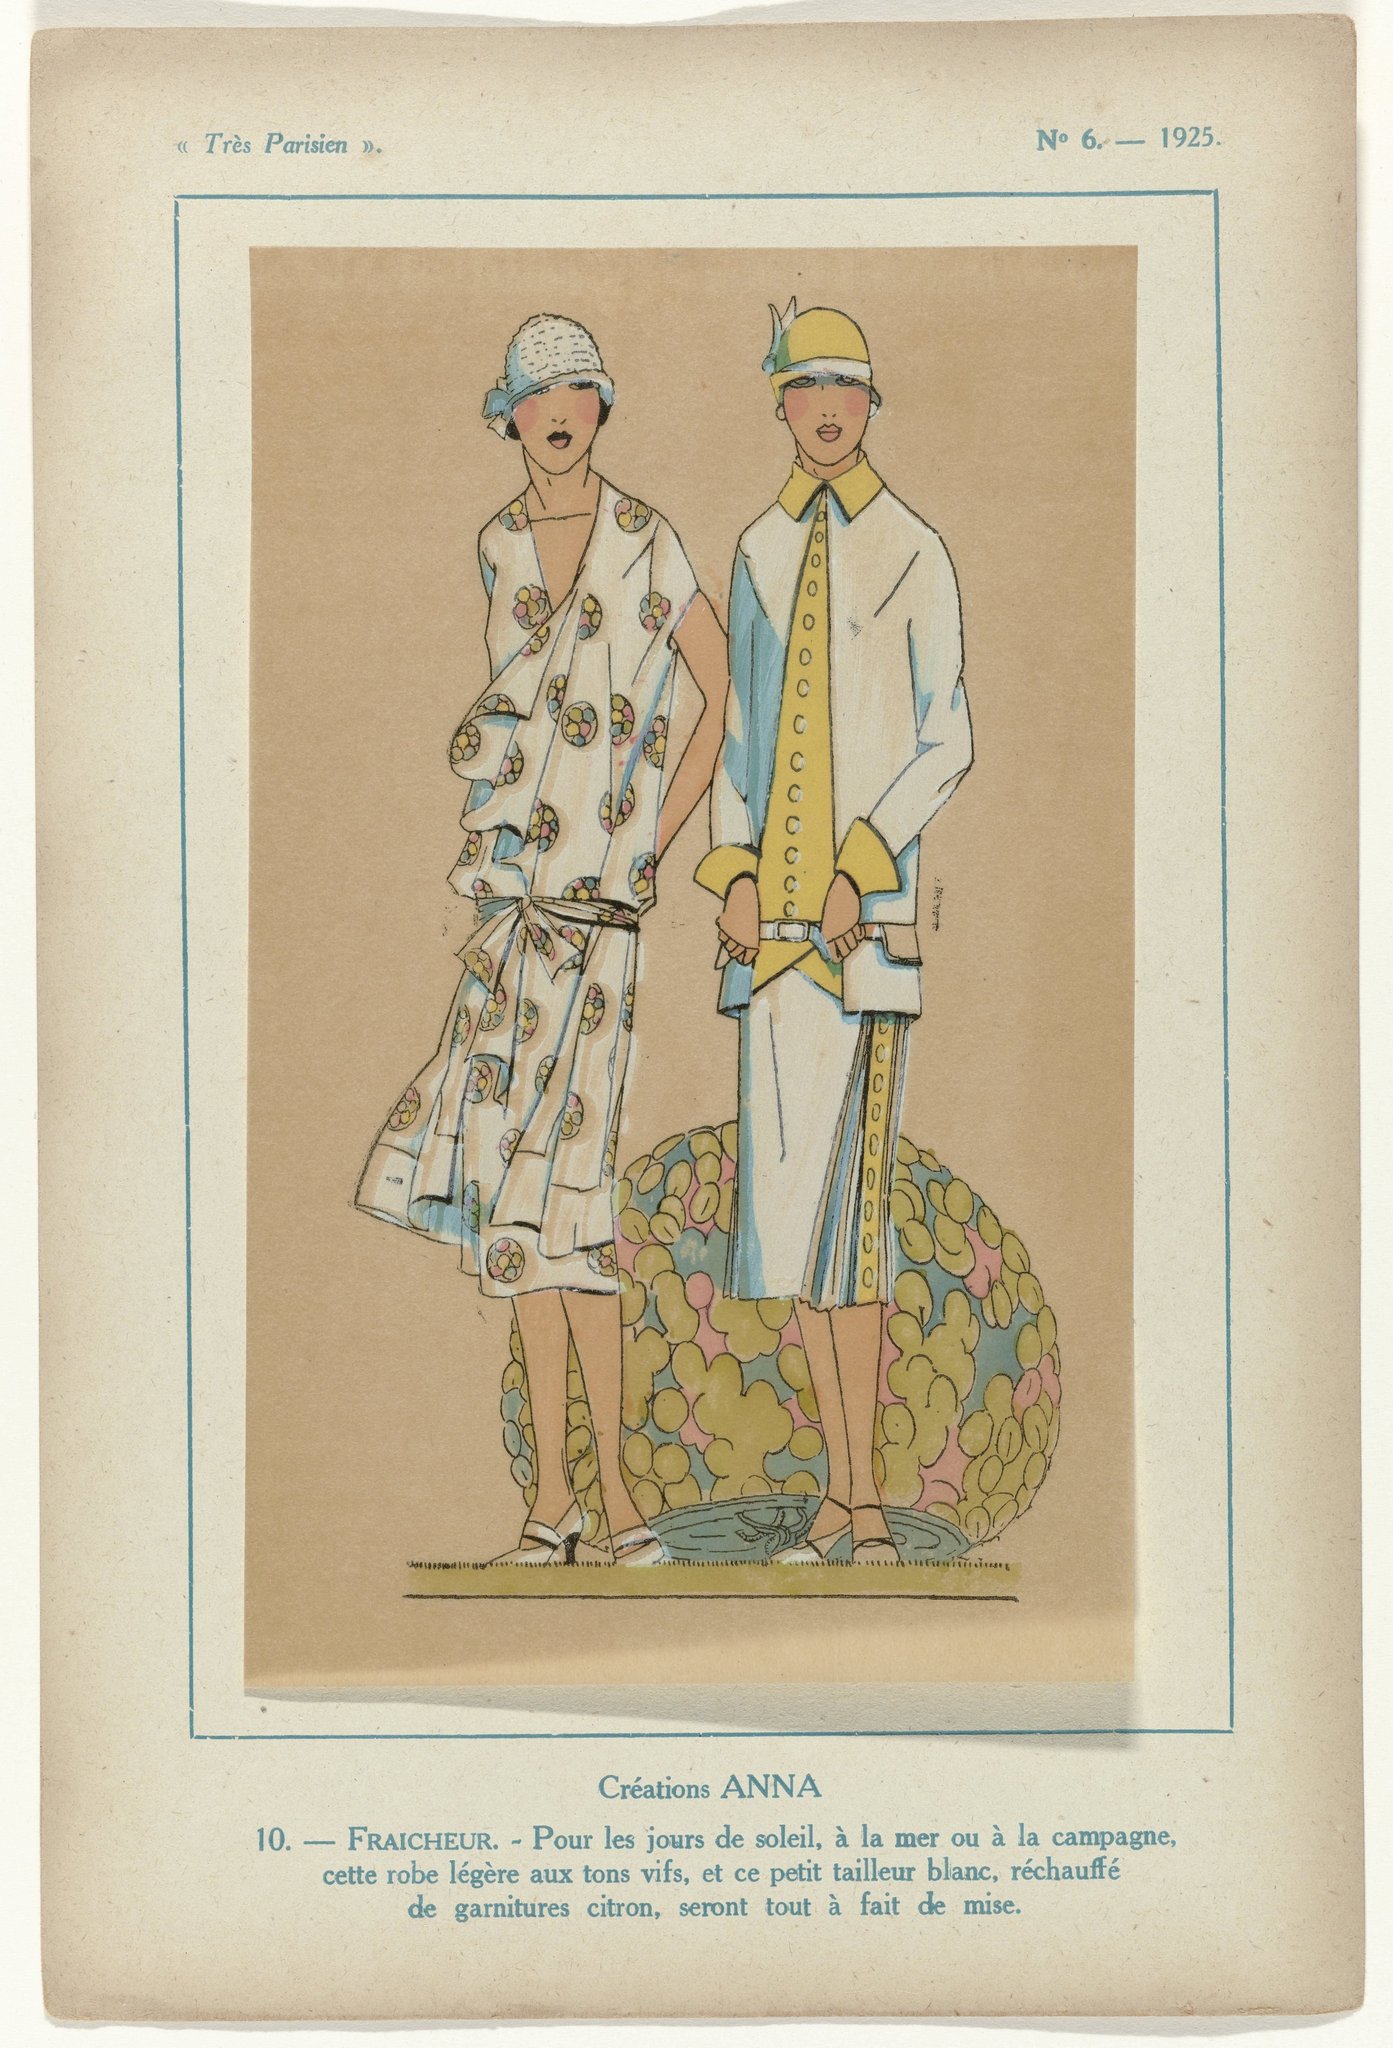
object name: fashion print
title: Très Parisien, 1925, No. 6, pl. 19: Créations ANNA. -FRAICHEUR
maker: g-p. joumard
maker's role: publisher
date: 1925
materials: paper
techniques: hand coloring, letterpress printing, lithography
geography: paris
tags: dress, gown: day dress (+ women's clothes), ensembles of pieces of clothing (tailleur) (+ women's clothes), fashion plates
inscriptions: caption: ‘10. - FRAICHEUR. - Pour les jours de soleil, à la mer ou à la campagne, cette robe légère aux tons vifs, et ce petit tailleur blanc, réchauffé de garnitures citron, seront tout à fait de mise.’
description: Luchtige japon en zomers mantelpak voor aan zee of op het platteland. Prent uit het modetijdschrift Très Parisien...La Mode, Le Chic, L' Élégance (1920-1936)